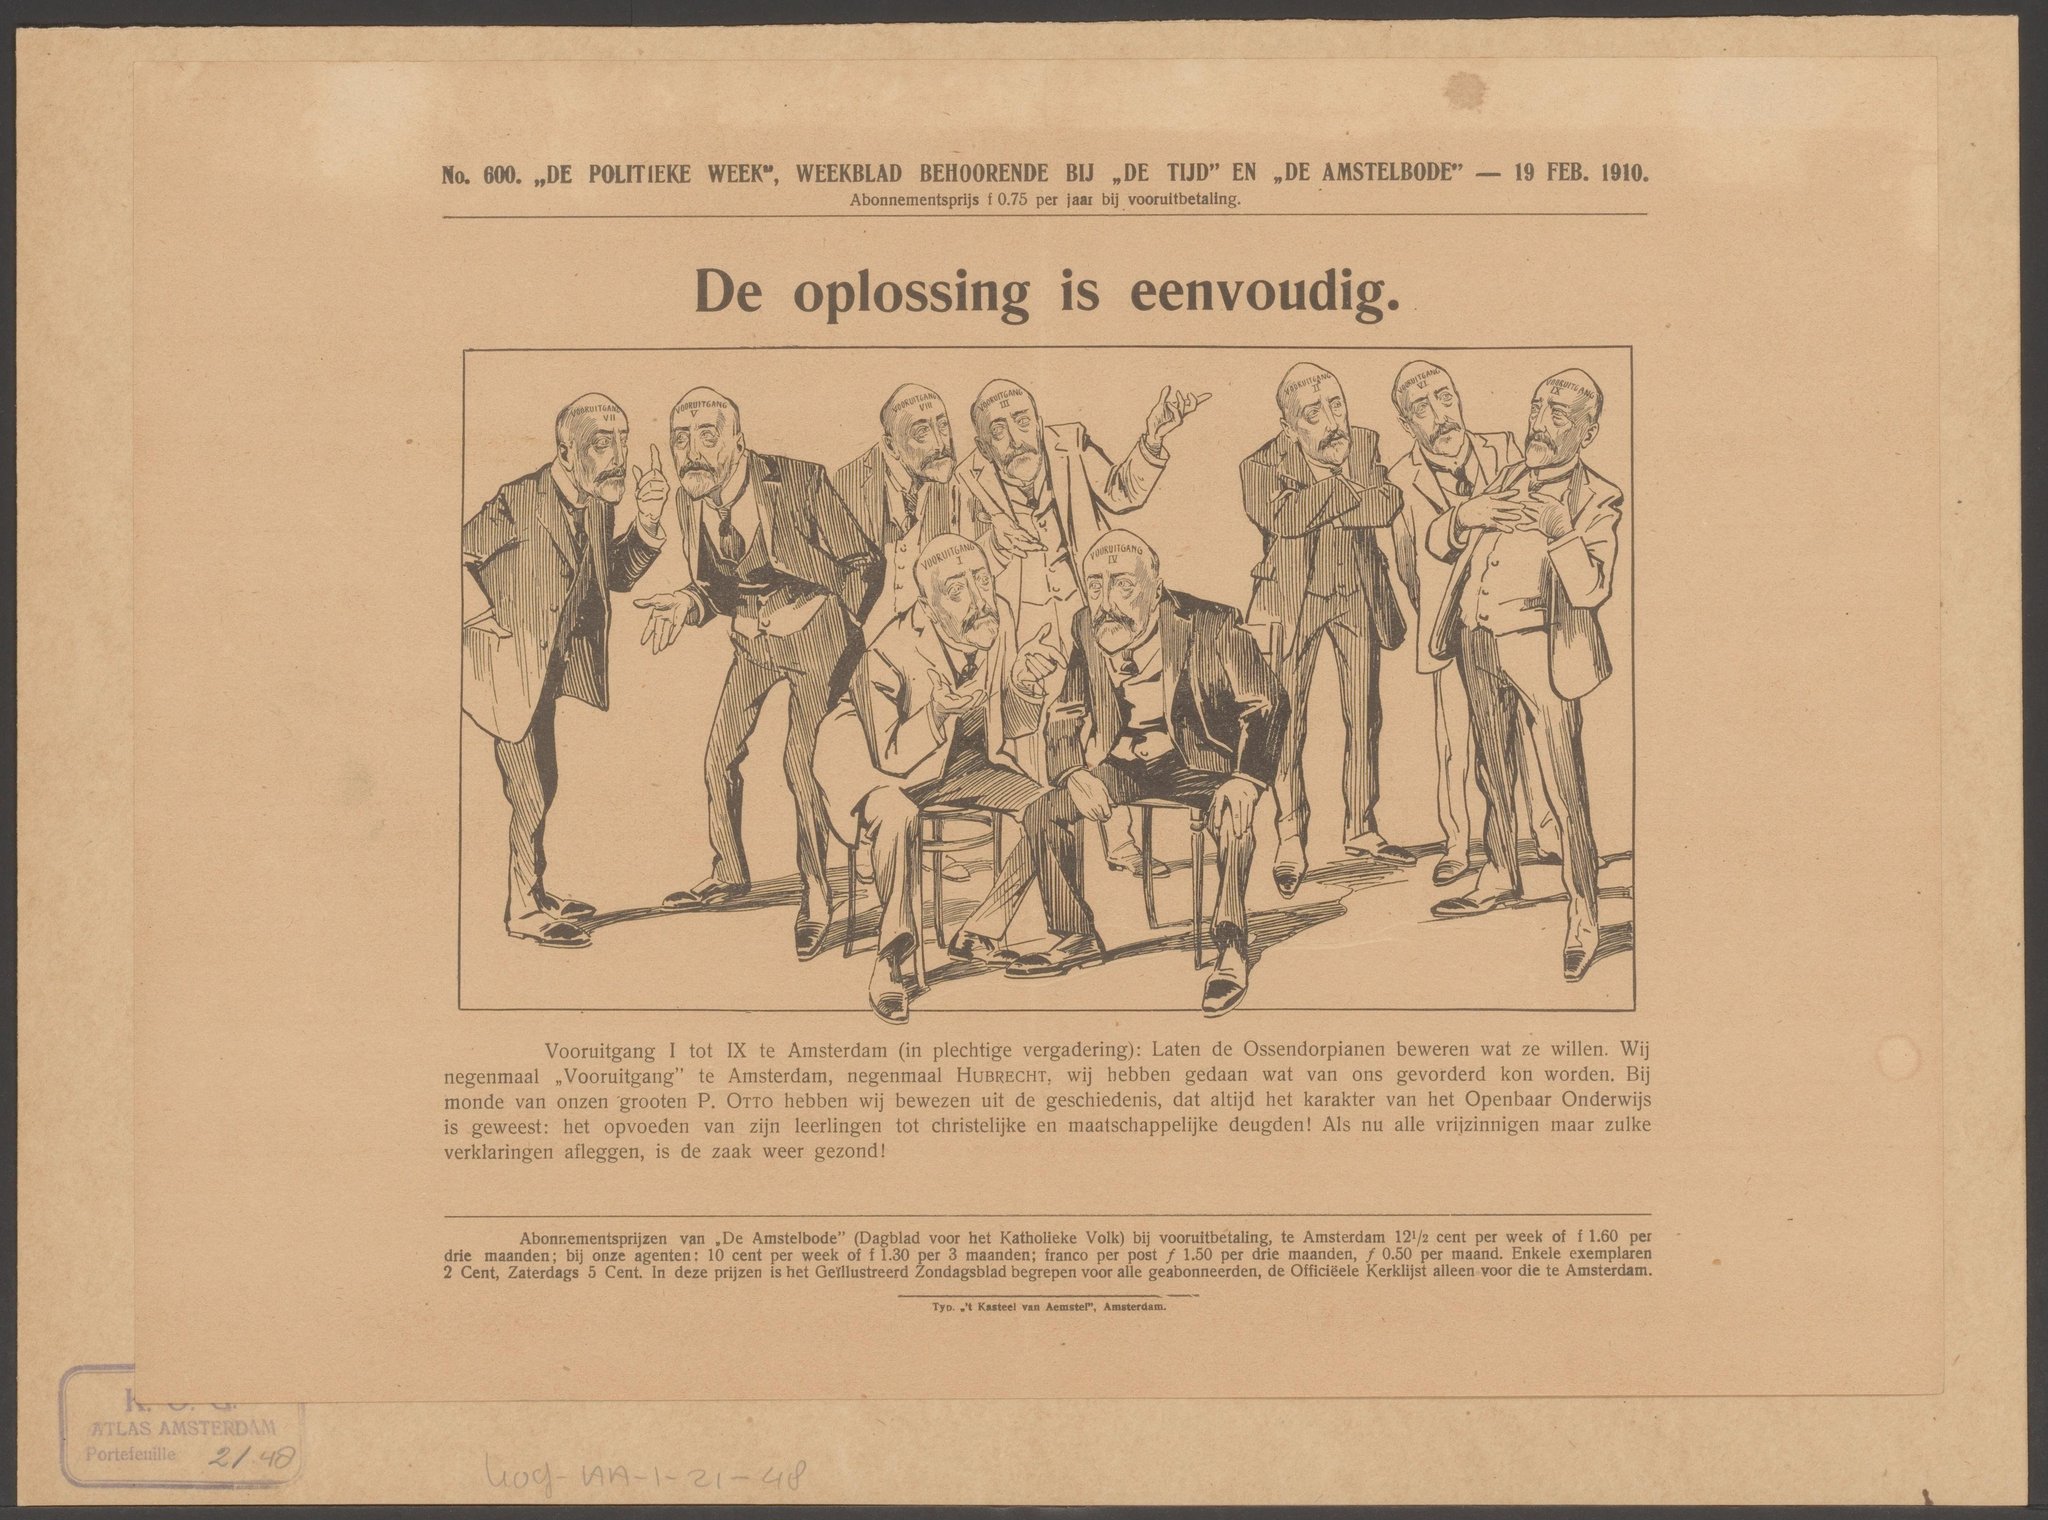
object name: photomechanical print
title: De oplossing is eenvoudig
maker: Anonymous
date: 1910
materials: paper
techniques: letterpress printing, line block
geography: amsterdam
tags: politician, e.g. party leader, political caricatures and satires, amsterdam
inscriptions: collector's mark: Lugt 1641b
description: Onderwerpsrubriek binnen de Atlas Amsterdam: Kiesverenigingen, Politieke partijen.